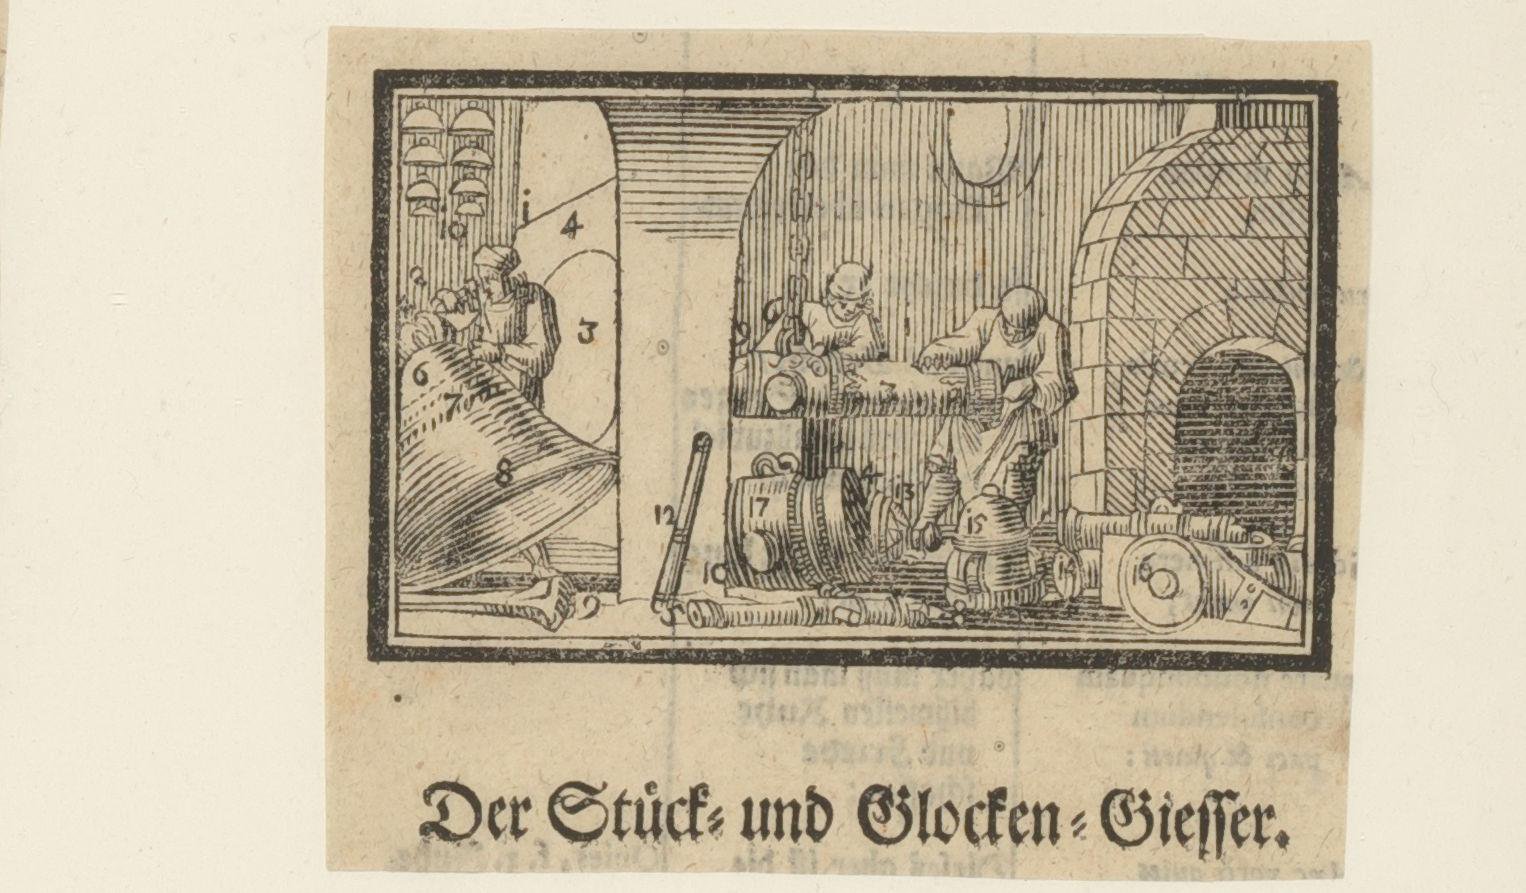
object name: print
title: Der Stuck- und Klocken-Giesser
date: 1719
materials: paper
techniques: letterpress printing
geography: nuremberg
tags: handicrafts, craftsman at work, church bell, smith, blacksmith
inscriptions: stamp, collector's mark: Lugt 1641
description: Prent uit: Comenius, Johannes Amosius. Orbis sensualium picti pars prima (...). Neurenberg: Martin Endter, 1719, dl. 2, p. 266. Prent eerder gebruikt in: Comenius, Johannes Amosius. Orbis Sensualium Picti denuo aucti Pars Secunda (...). Neurenberg: Martin Endter, 1730, dl. 2.